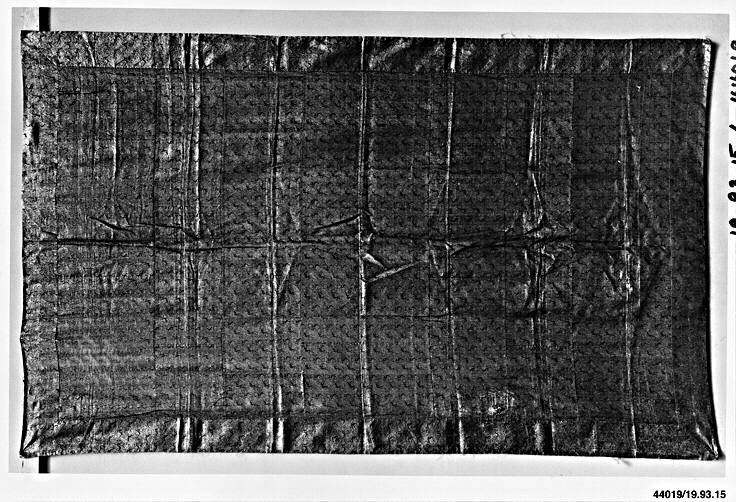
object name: robe, priest's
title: Priest's Robe (Shichijō)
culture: japanese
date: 1401-1500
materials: metal thread, silk